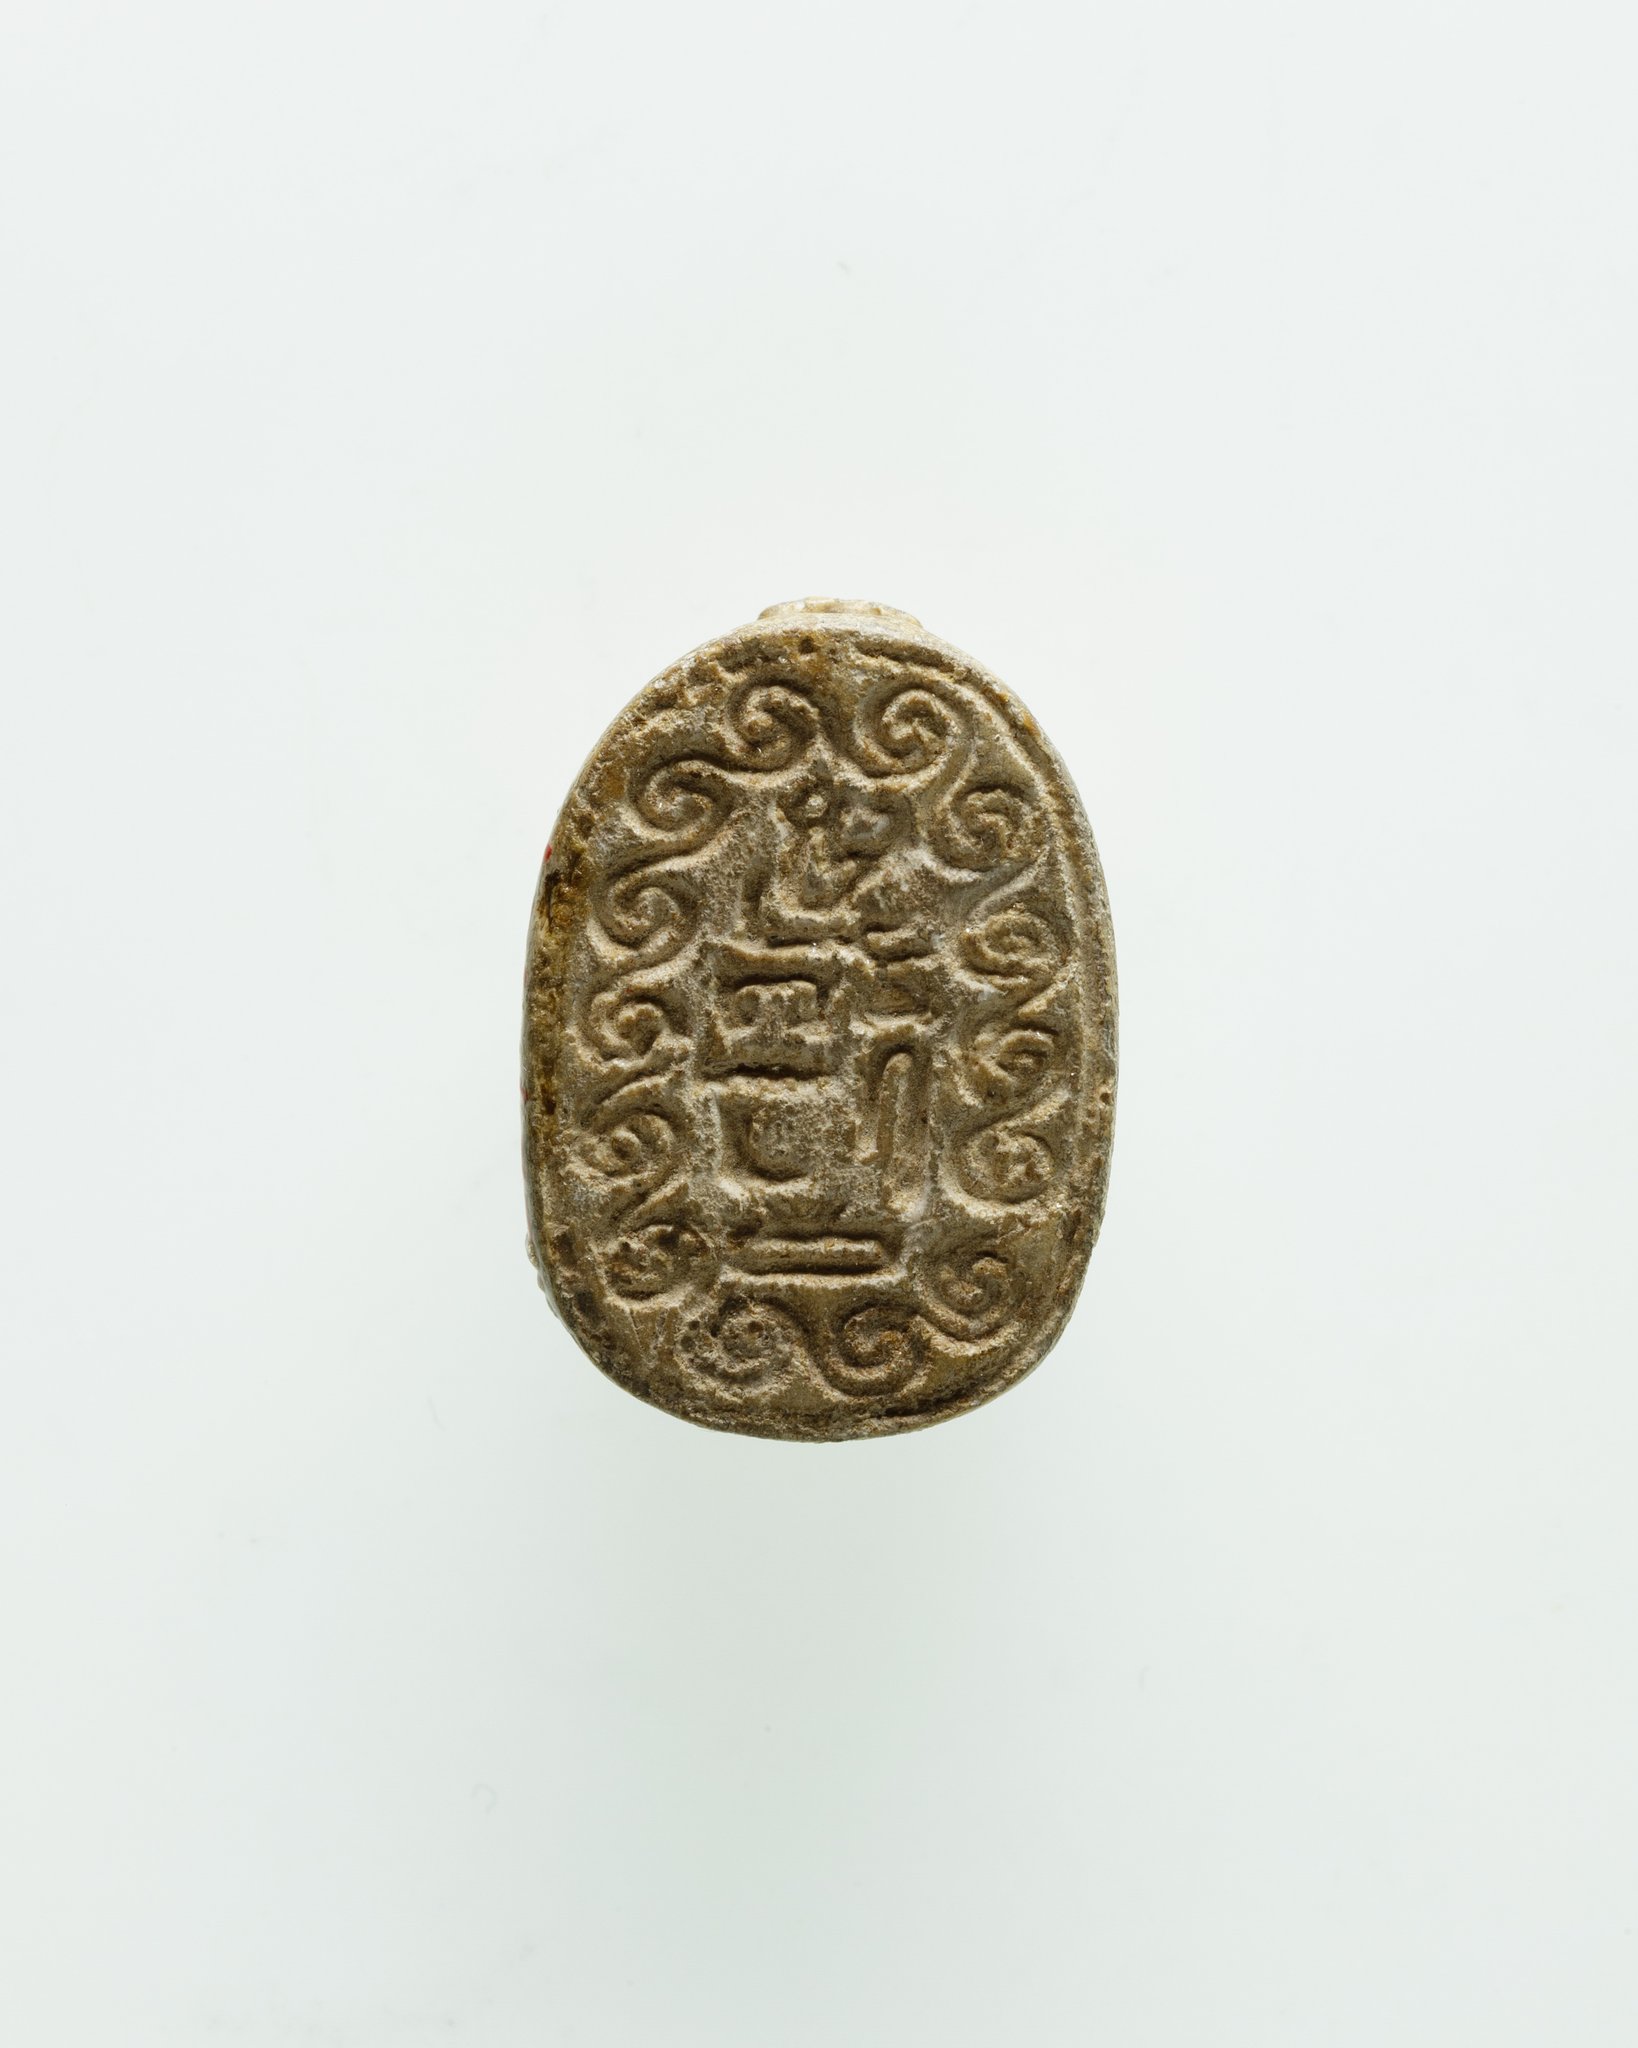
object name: scarab, official, private name and title, seneb, hall keeper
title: Scarab of an Official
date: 1760-1670 BCE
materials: stone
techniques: glazing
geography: egypt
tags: scarabs